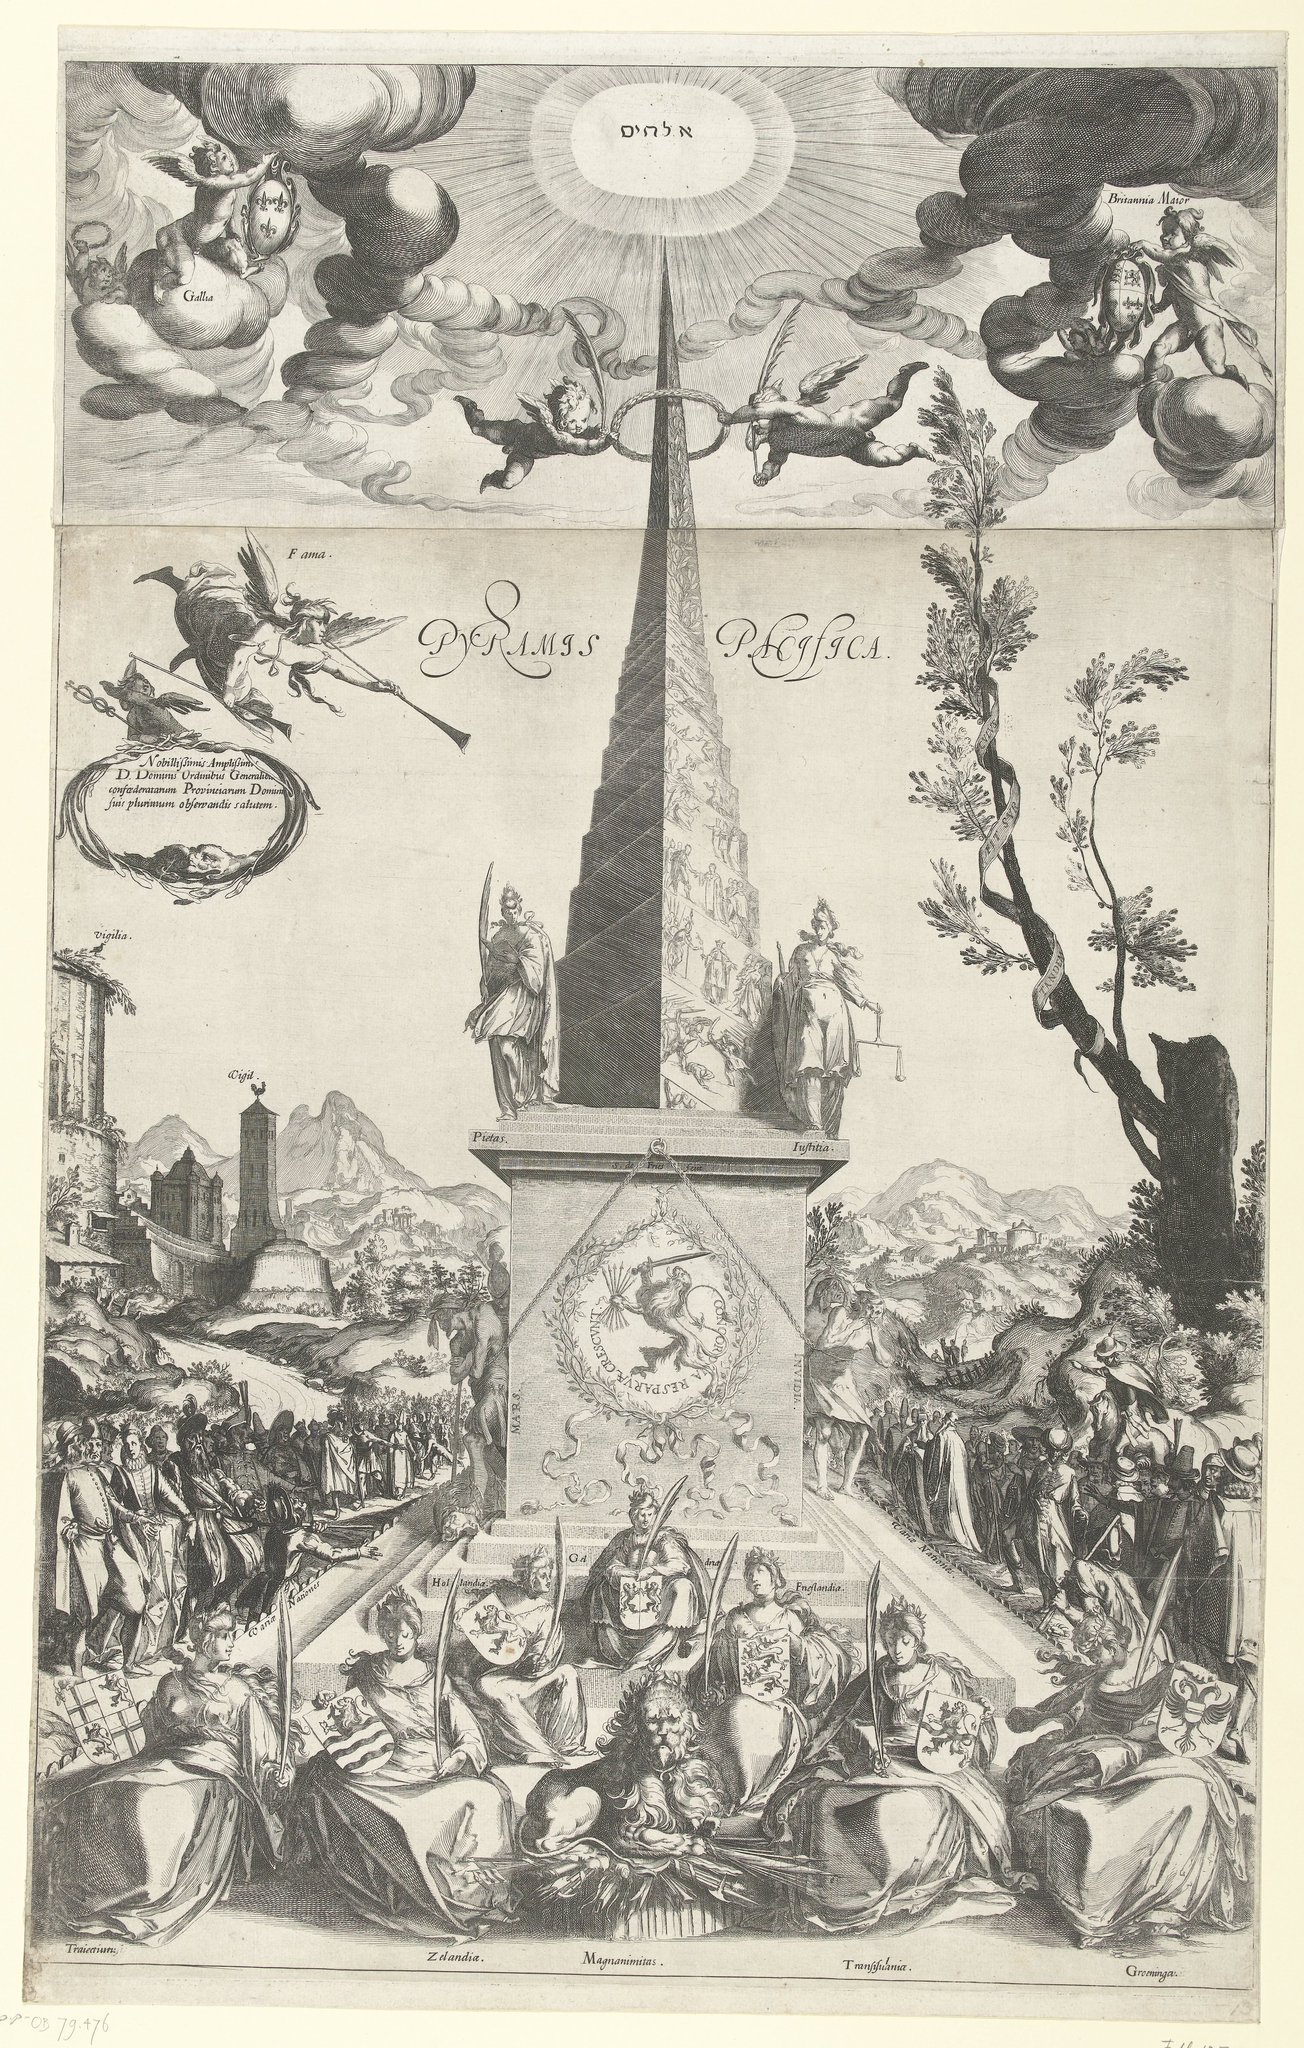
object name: propagandaprent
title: Piramide van de Vrede, 1609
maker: simon frisius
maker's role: print maker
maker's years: 1570-1628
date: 1609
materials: paper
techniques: engraving, etching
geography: netherlands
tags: 'pietas'; 'pietà' (ripa), justice, 'justitia'; 'giustitia divina' (ripa) ~ one of the four cardinal virtues, envy; 'invidia' (ripa) ~ personification of one of the seven deadly sins, symbols, allegories of peace, 'pax'; 'pace' (ripa), specific aspects, allegorical aspects of mars; mars as patron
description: Piramide van de Vrede, 1609. Allegorie op het Twaalfjarig Bestand, gedrukt van twee platen. Hoog naaldvormige piramide of obelisk, geflankeerd door de personificaties van Vroomheid (Pietas) en Rechtvaardigheid (Justitia). Op de voorgrond de zeven provinciemaagden met wapens gezeten rond de Hollandse Leeuw. Vastgeketend aan het voetstuk de personificaties van Oorlog (Mars) en Afgunst (Invidia). Aan weerszijden toeschouwers uit alle landen van de wereld. Rechts de spruitende oranjeboom, links de Faam bij een cartouche met de opdracht in het Latijn. In de hemel engelen met de wapens van Frankrijk en Groot-Brittannië, in het midden het stralende tetragram.